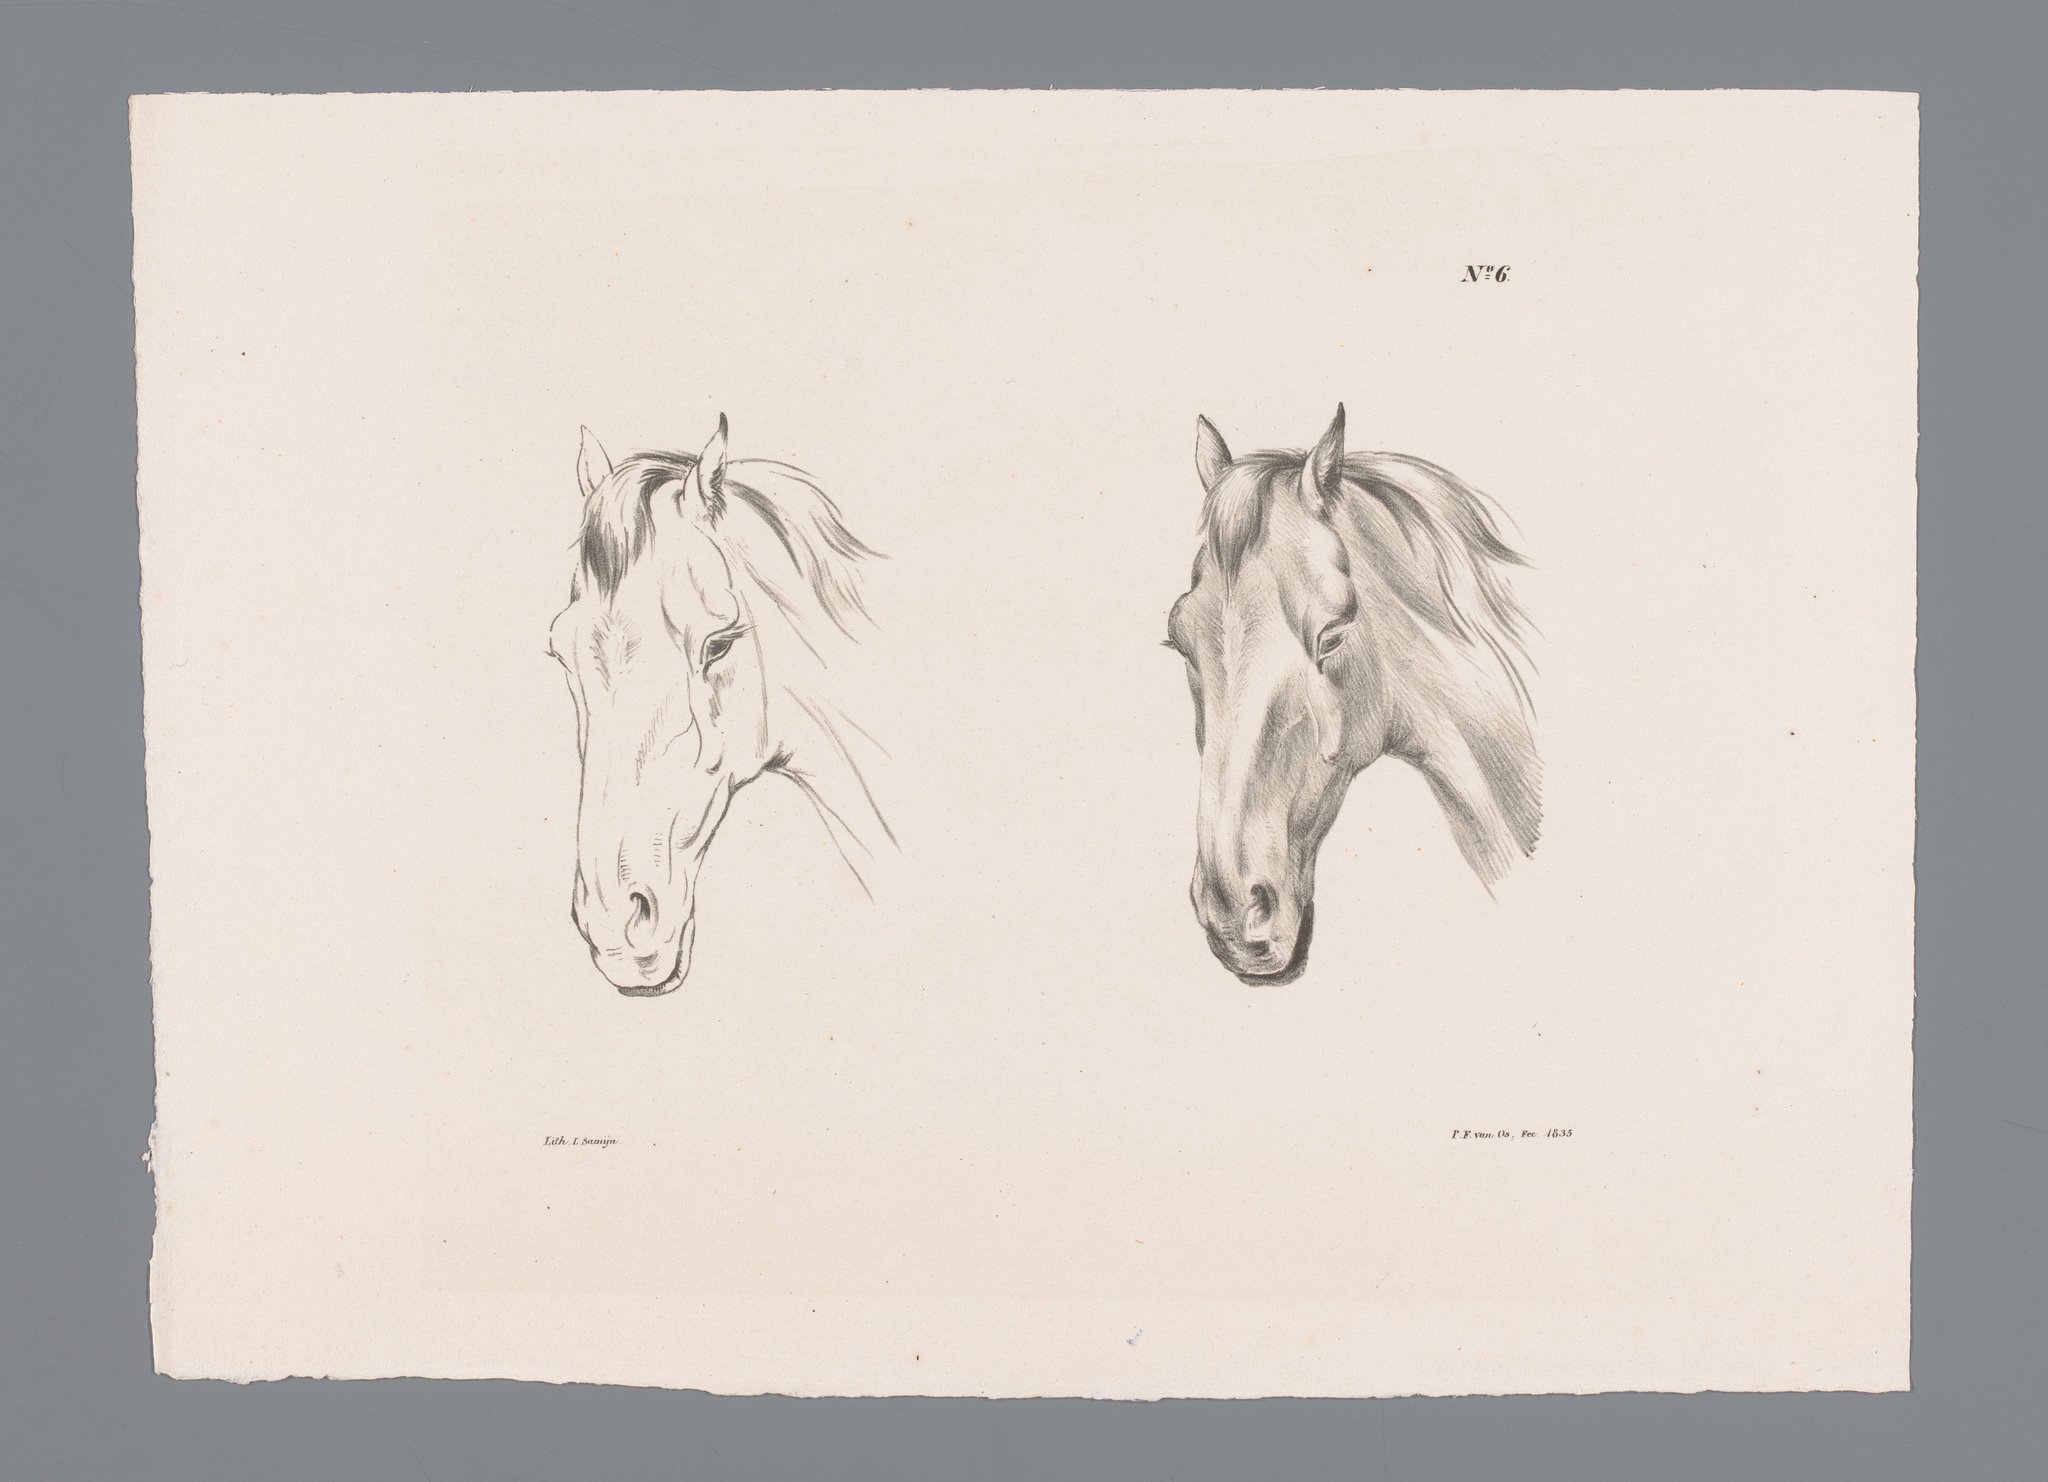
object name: print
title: Twee studies van een paardenhoofd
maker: l. samijn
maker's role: printer, publisher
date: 1835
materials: paper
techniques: lithograph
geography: amsterdam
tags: animals (+ head of an animal), horse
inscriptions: collector's mark: Lugt 2228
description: Onderdeel van een omslag met een serie van tien paardenstudies.